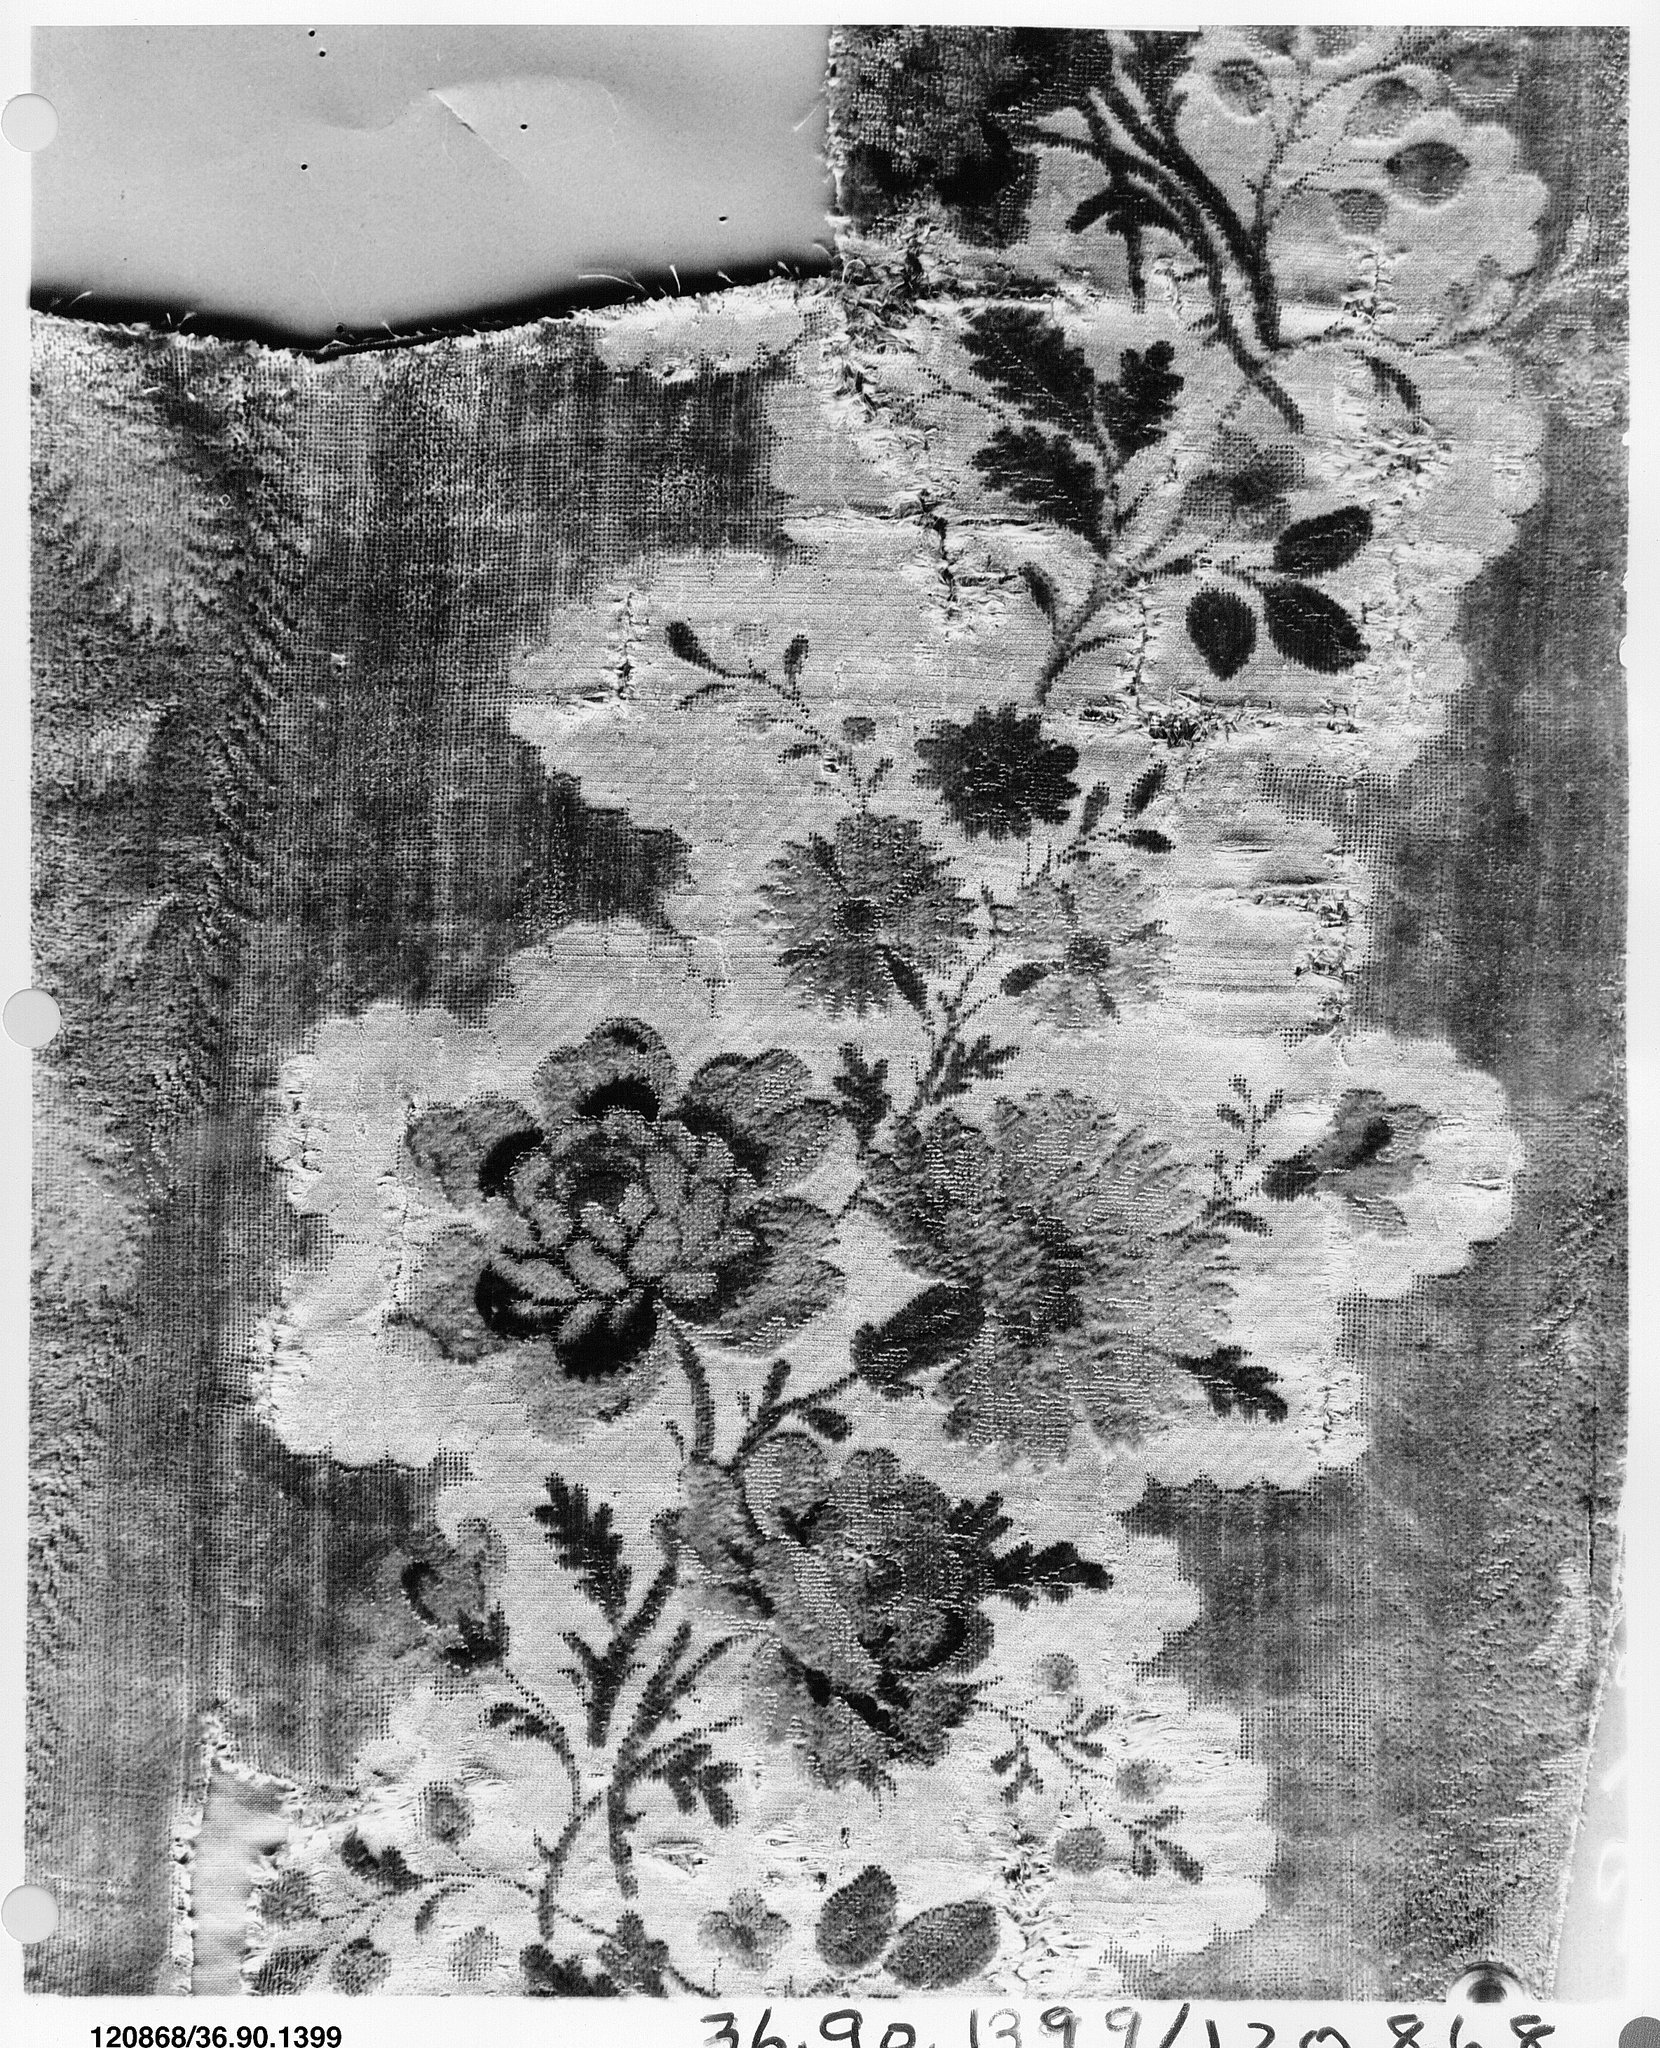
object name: piece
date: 1701-1800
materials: silk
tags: flowers,leaves